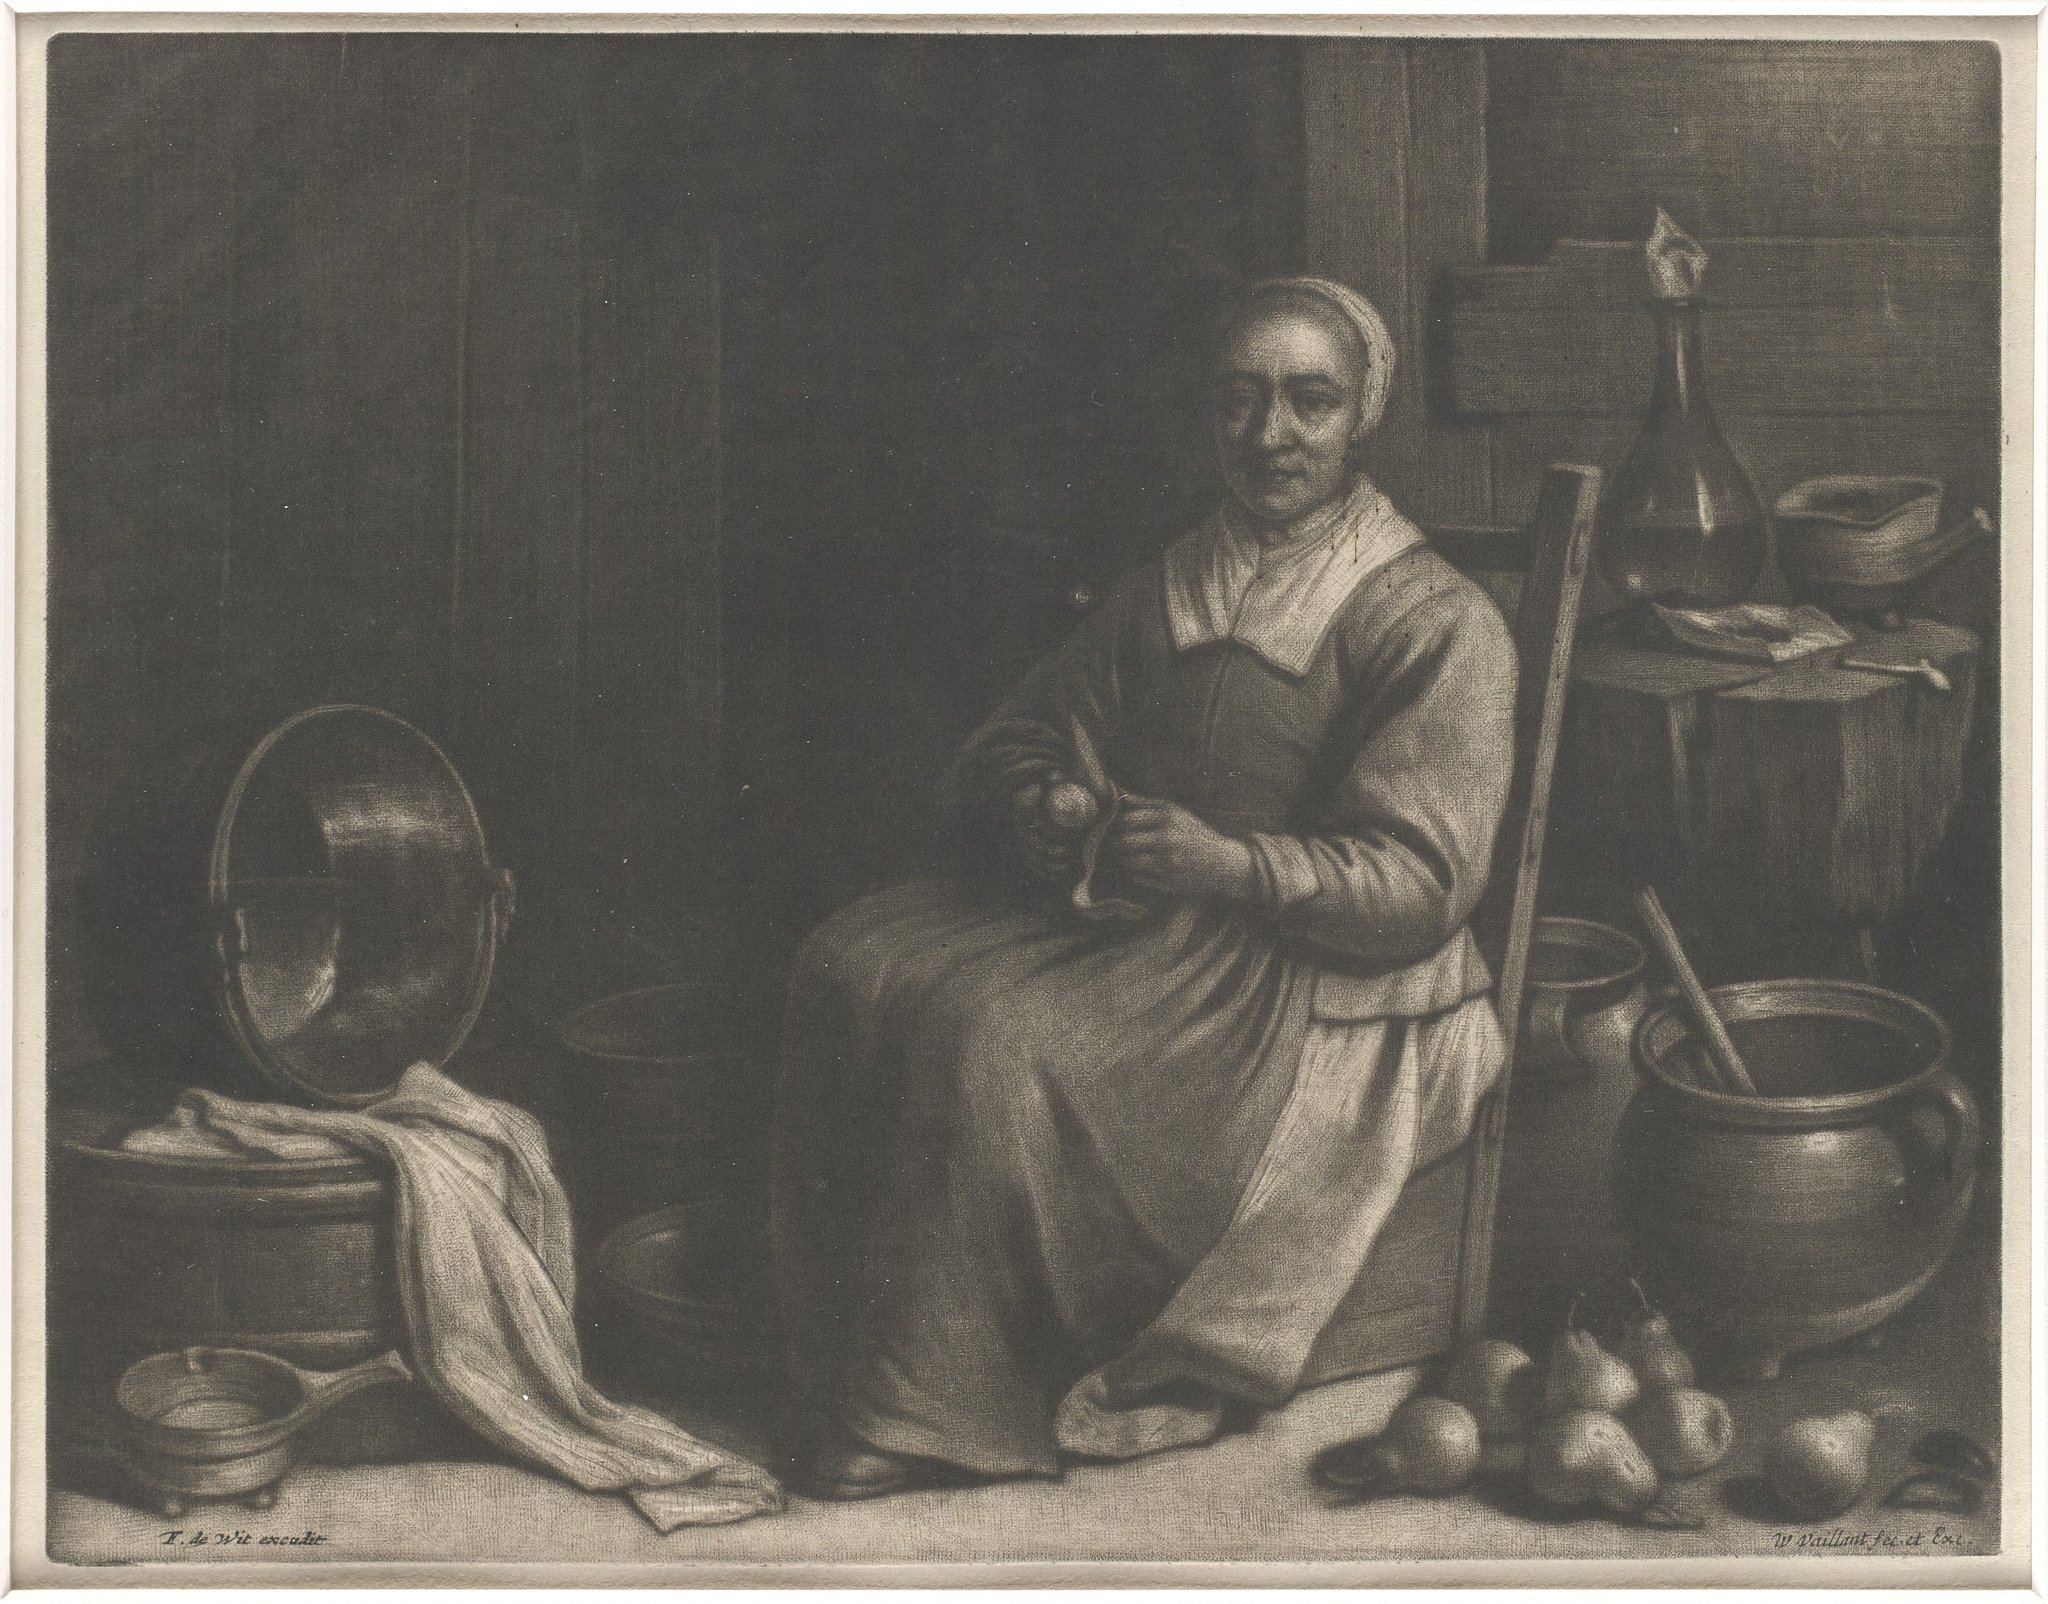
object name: print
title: A Woman Peeling Pears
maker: wallerant vaillant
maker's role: artist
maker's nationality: dutch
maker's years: 1623-1677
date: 1634-1666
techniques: mezzotint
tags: food,pears,women